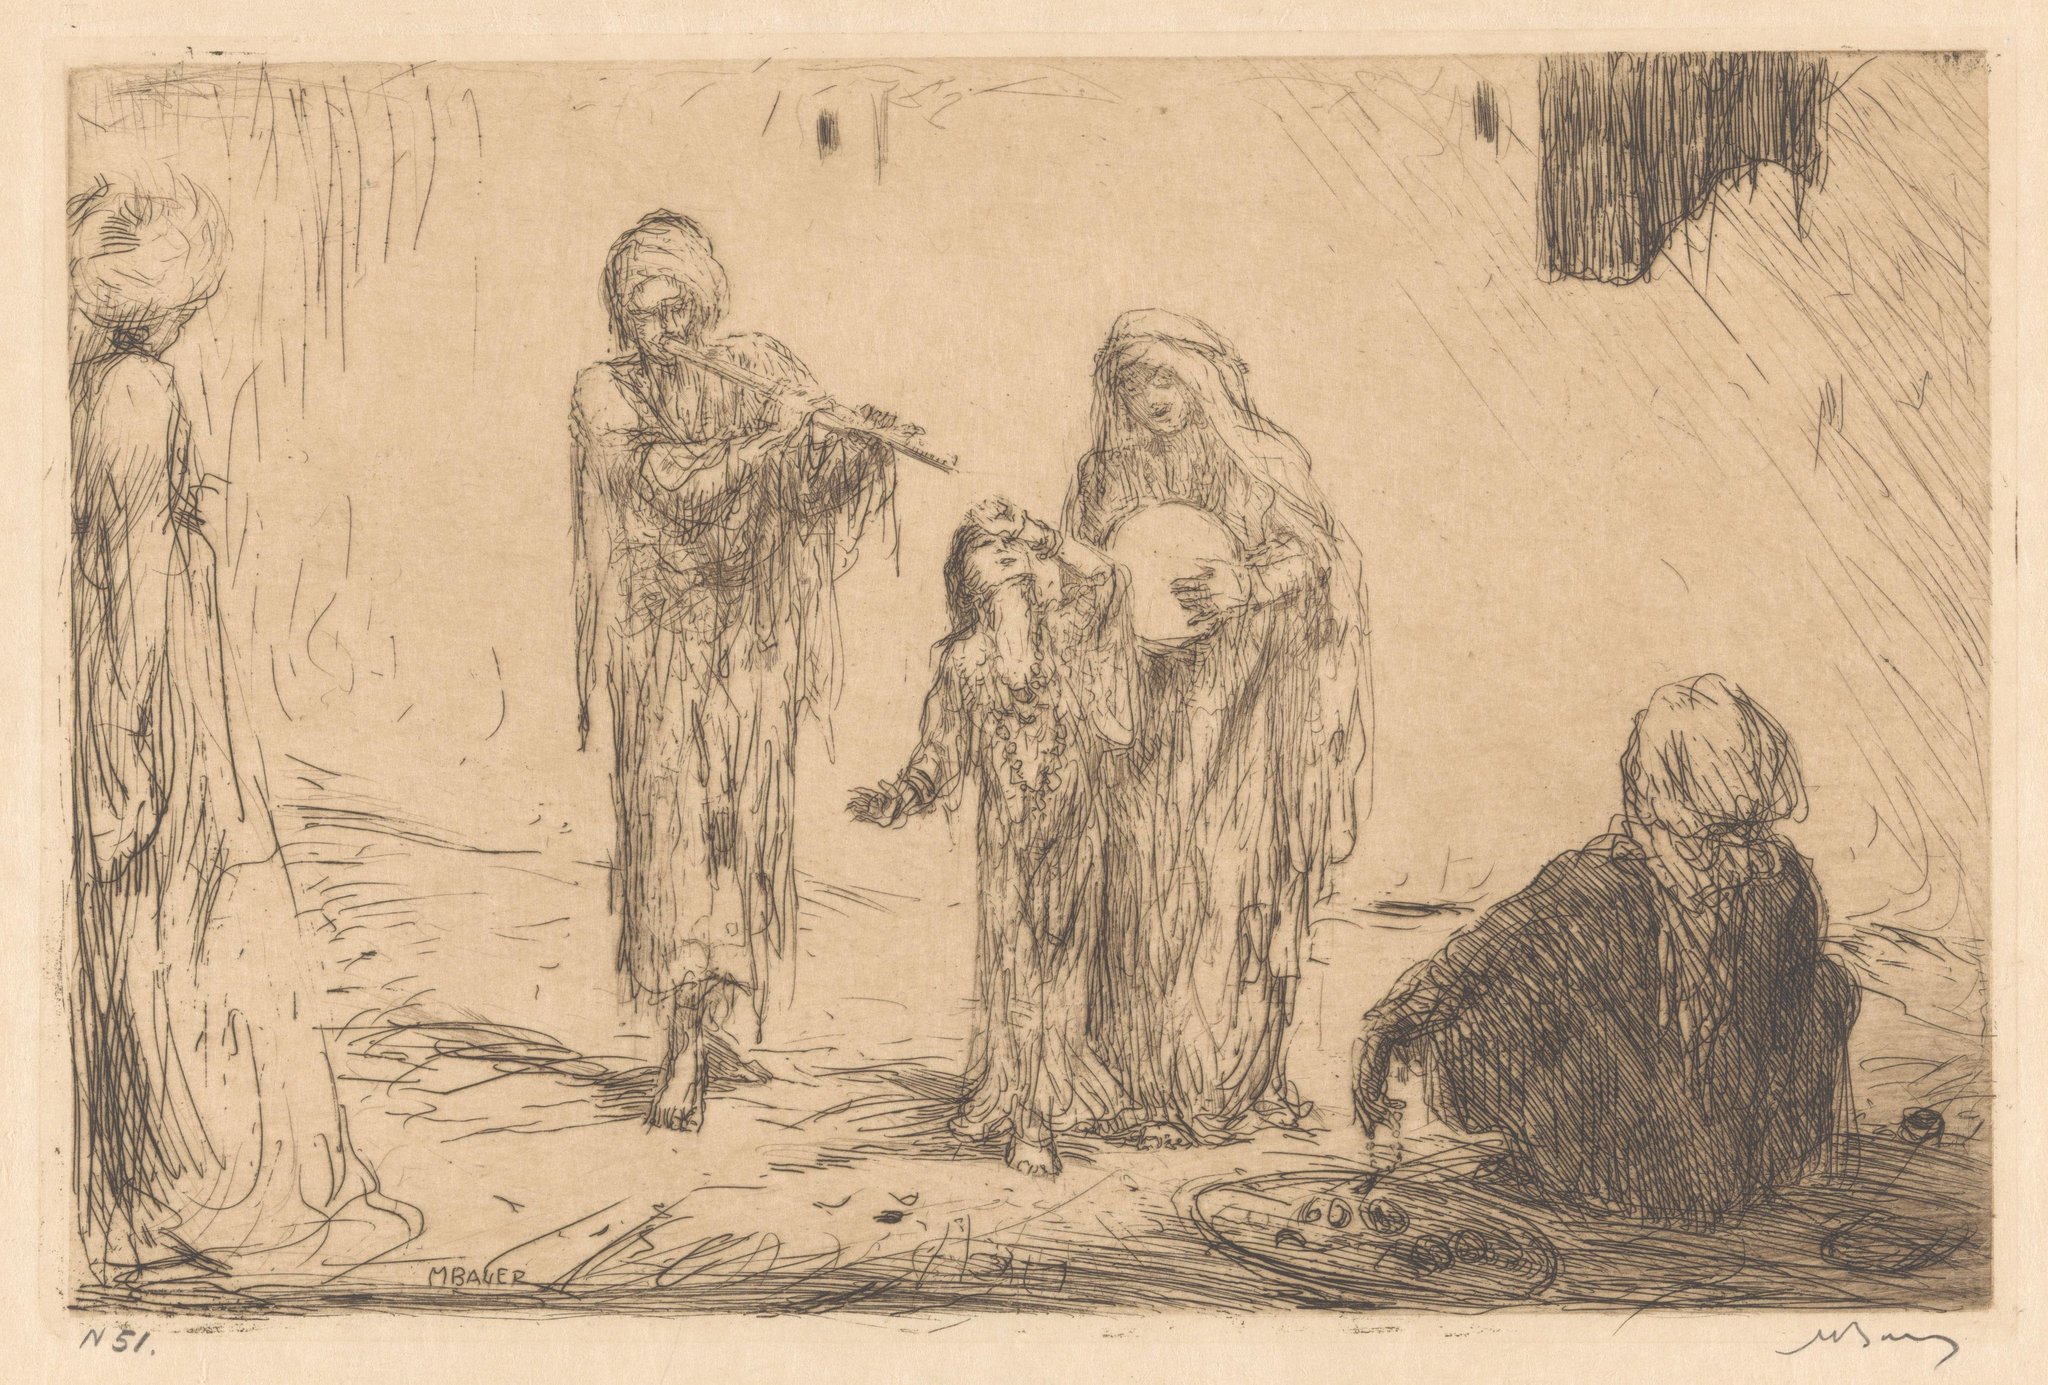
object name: print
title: Dansend meisje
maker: marius bauer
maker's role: draughtsman, print maker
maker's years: 1867-1932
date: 1926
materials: paper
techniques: etching, intaglio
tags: woman dancing alone, tambourine, girl (child between toddler and youth), flute, aulos, tibia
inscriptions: collector's mark: Lugt 2228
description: Een meisje danst voor een man die een fluit bespeelt en een vrouw die op een tamboerijn slaat. Een staande en een zittende figuur kijken toe.